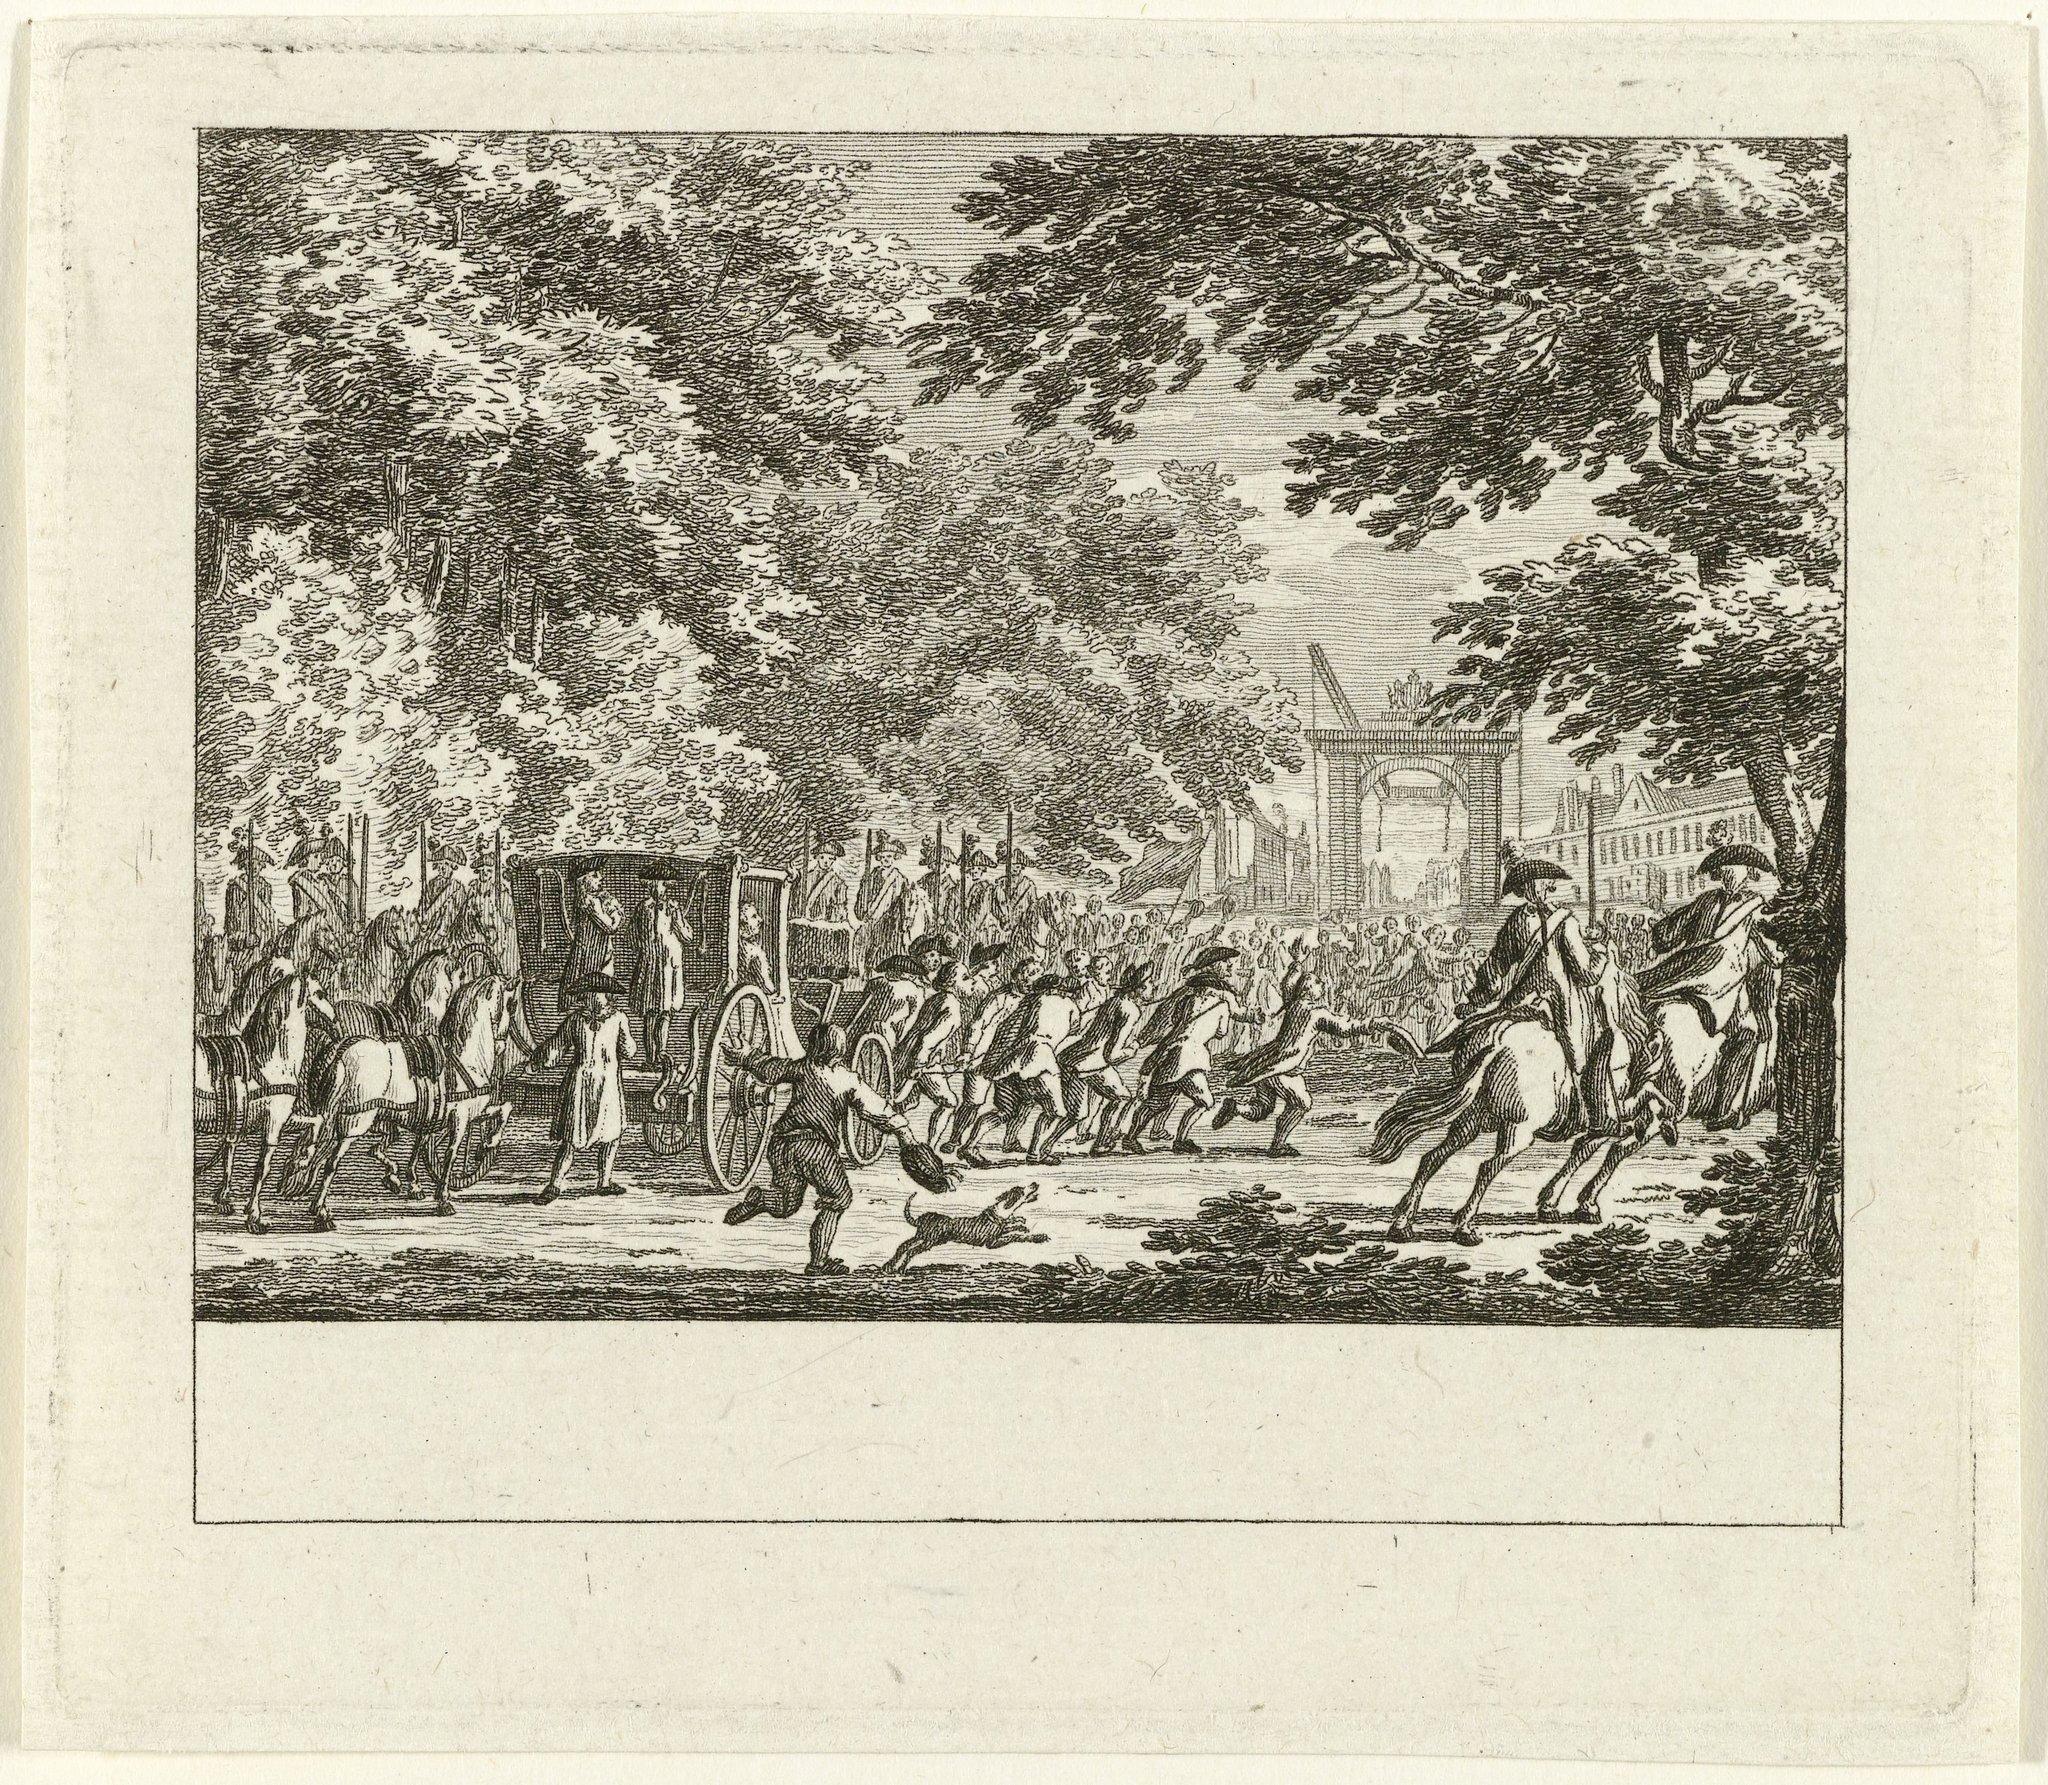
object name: print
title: Inhaling van de prins van Oranje, 1787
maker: Anonymous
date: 1787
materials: paper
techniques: etching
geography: northern netherlands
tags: william v (prince of orange), public festivities at other royal events, not meant or mentioned above, human being(s) drawing or pushing a vehicle not usually propelled by manpower, the hague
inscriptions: collector's mark: Lugt 2228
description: Inhaling van de prins van Oranje door de burgerij te Den Haag, 20 september 1787. De open koets met stadhouder Willem V wordt door mannen en vrouwen over de weg in de richting van een ophaalbrug getrokken.